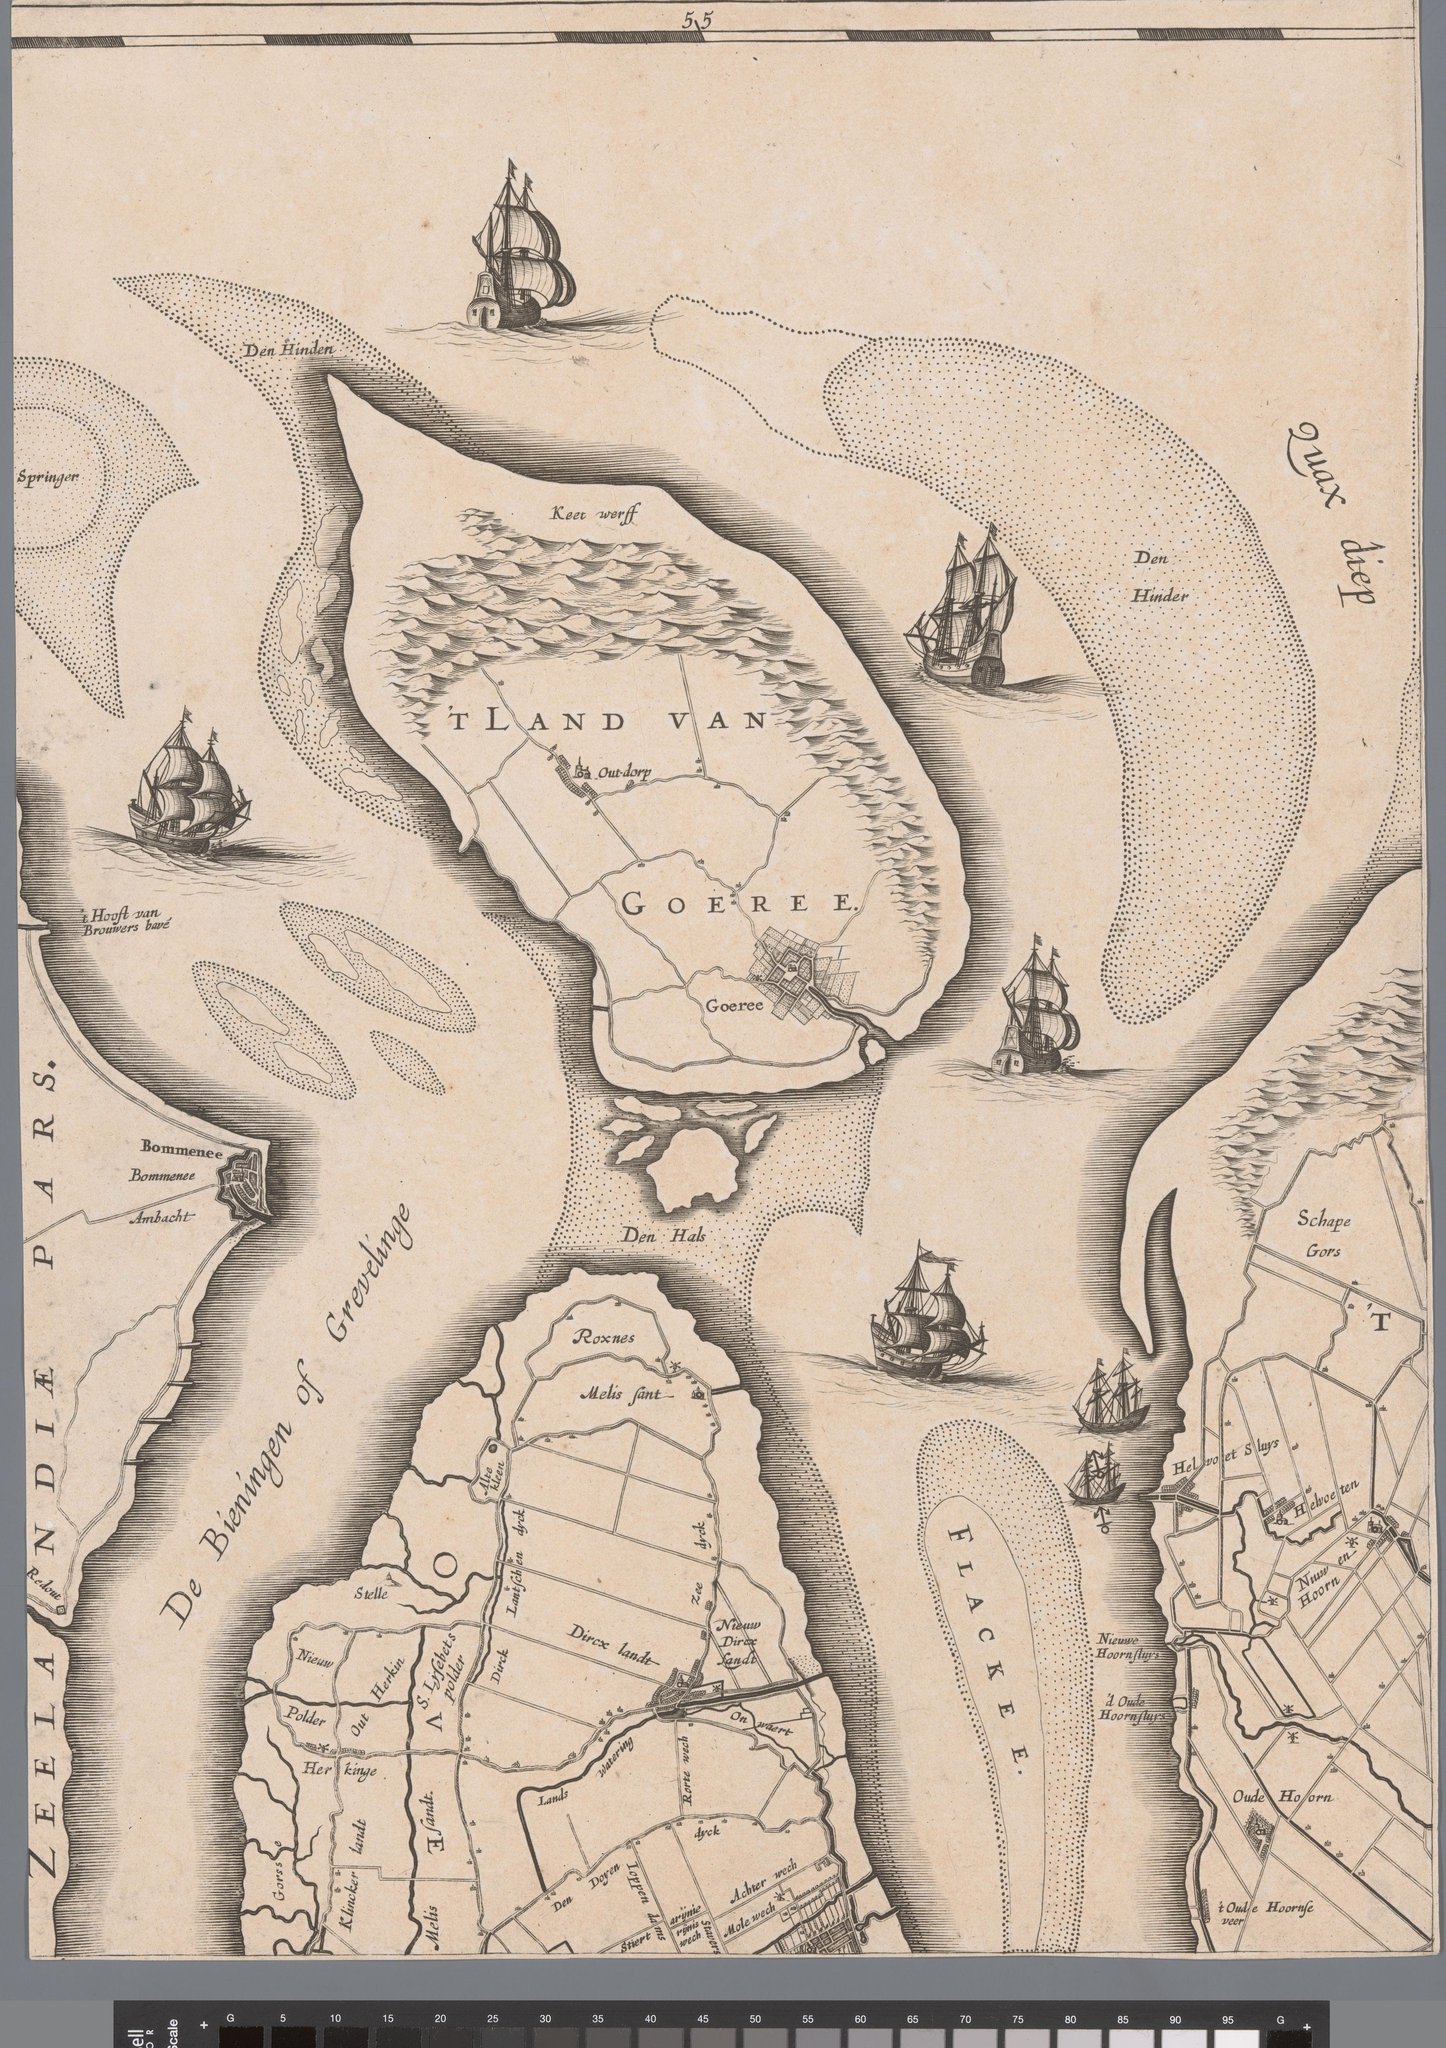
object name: print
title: Kaart van het Graafschap Holland en Utrecht (plaat 10)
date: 1639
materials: paper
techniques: engraving, etching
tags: sailing-ship, sailing-boat, maps, atlases, hellevoetsluis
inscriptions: collector's mark: Lugt 2228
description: Onderdeel van een kaart samengesteld uit 40 bladen. Waarschijnlijk gaat het om de grootste kaart van Holland uit de zeventiende-eeuw. De kaart is uitgegeven in verschillende edities, deze kaart uit 1639 is de eerste editie.